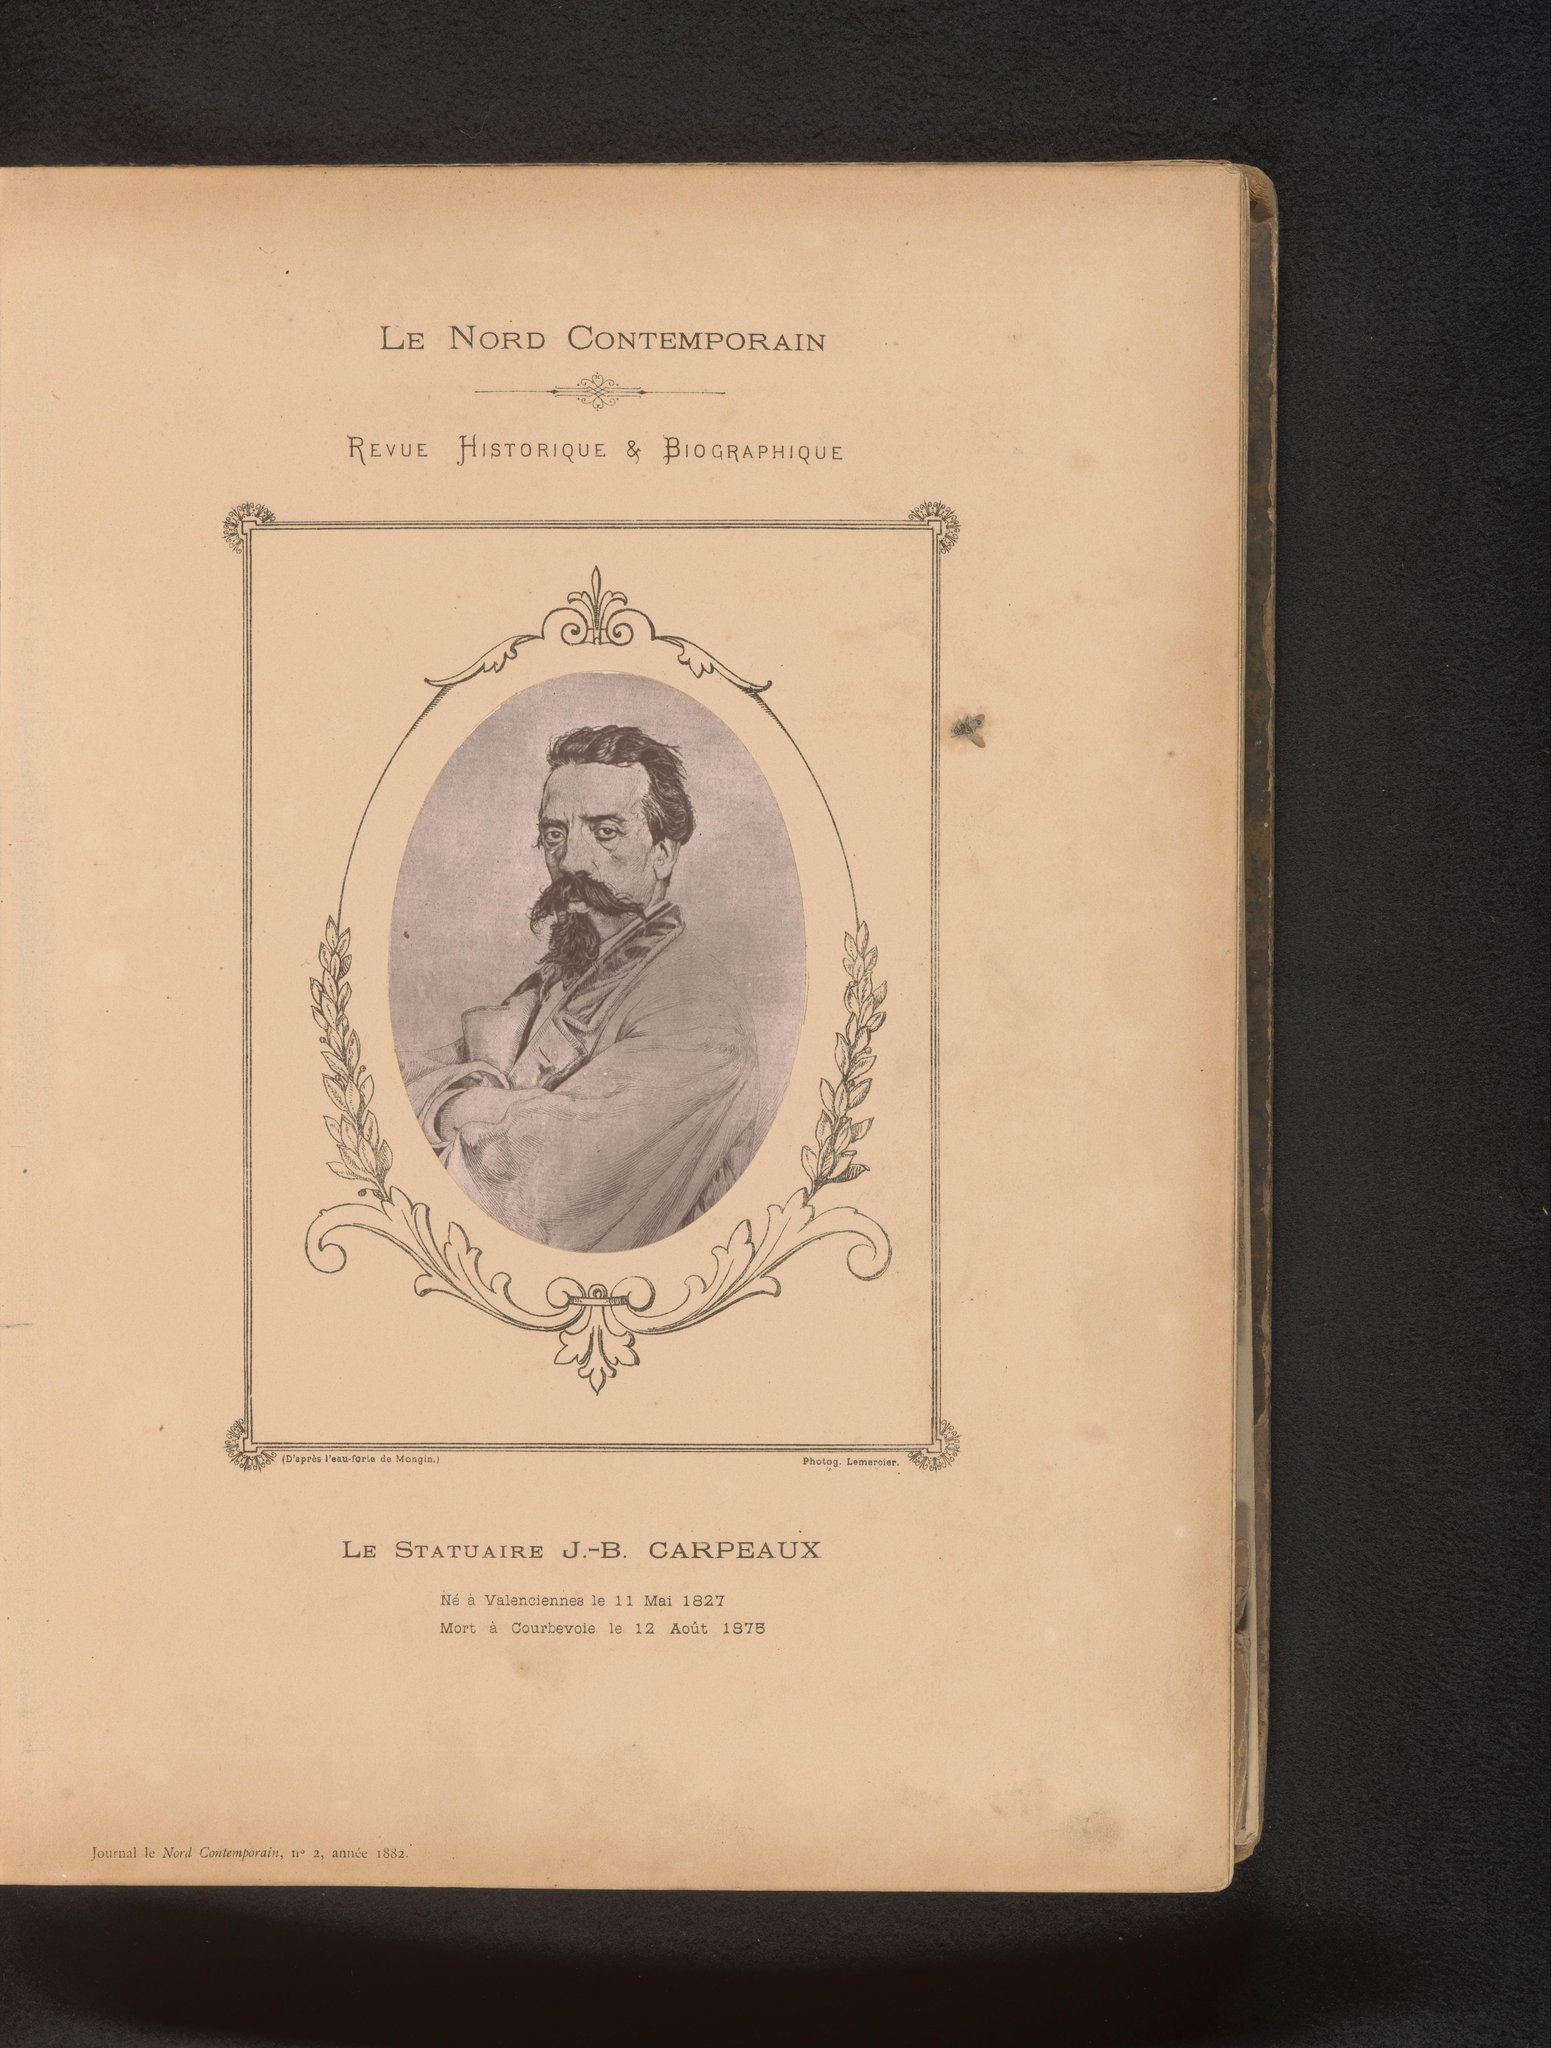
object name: photomechanical print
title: Le Statuaire J.B. Carpeaux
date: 1878-1882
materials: paper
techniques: woodburytype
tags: print maker, draughtsman, sculptor, jean baptiste carpeaux, historical persons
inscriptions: inscription: ‘Le Nord Contemporain/ Revue Historique & Biographique’, inscription: ‘Né à Valenciennes le 11 Mai 1827/ Mort à Courbevoie le 12 Août 1875’, inscription: ‘Journal le Nord Contemporain, No 2, année 1882’